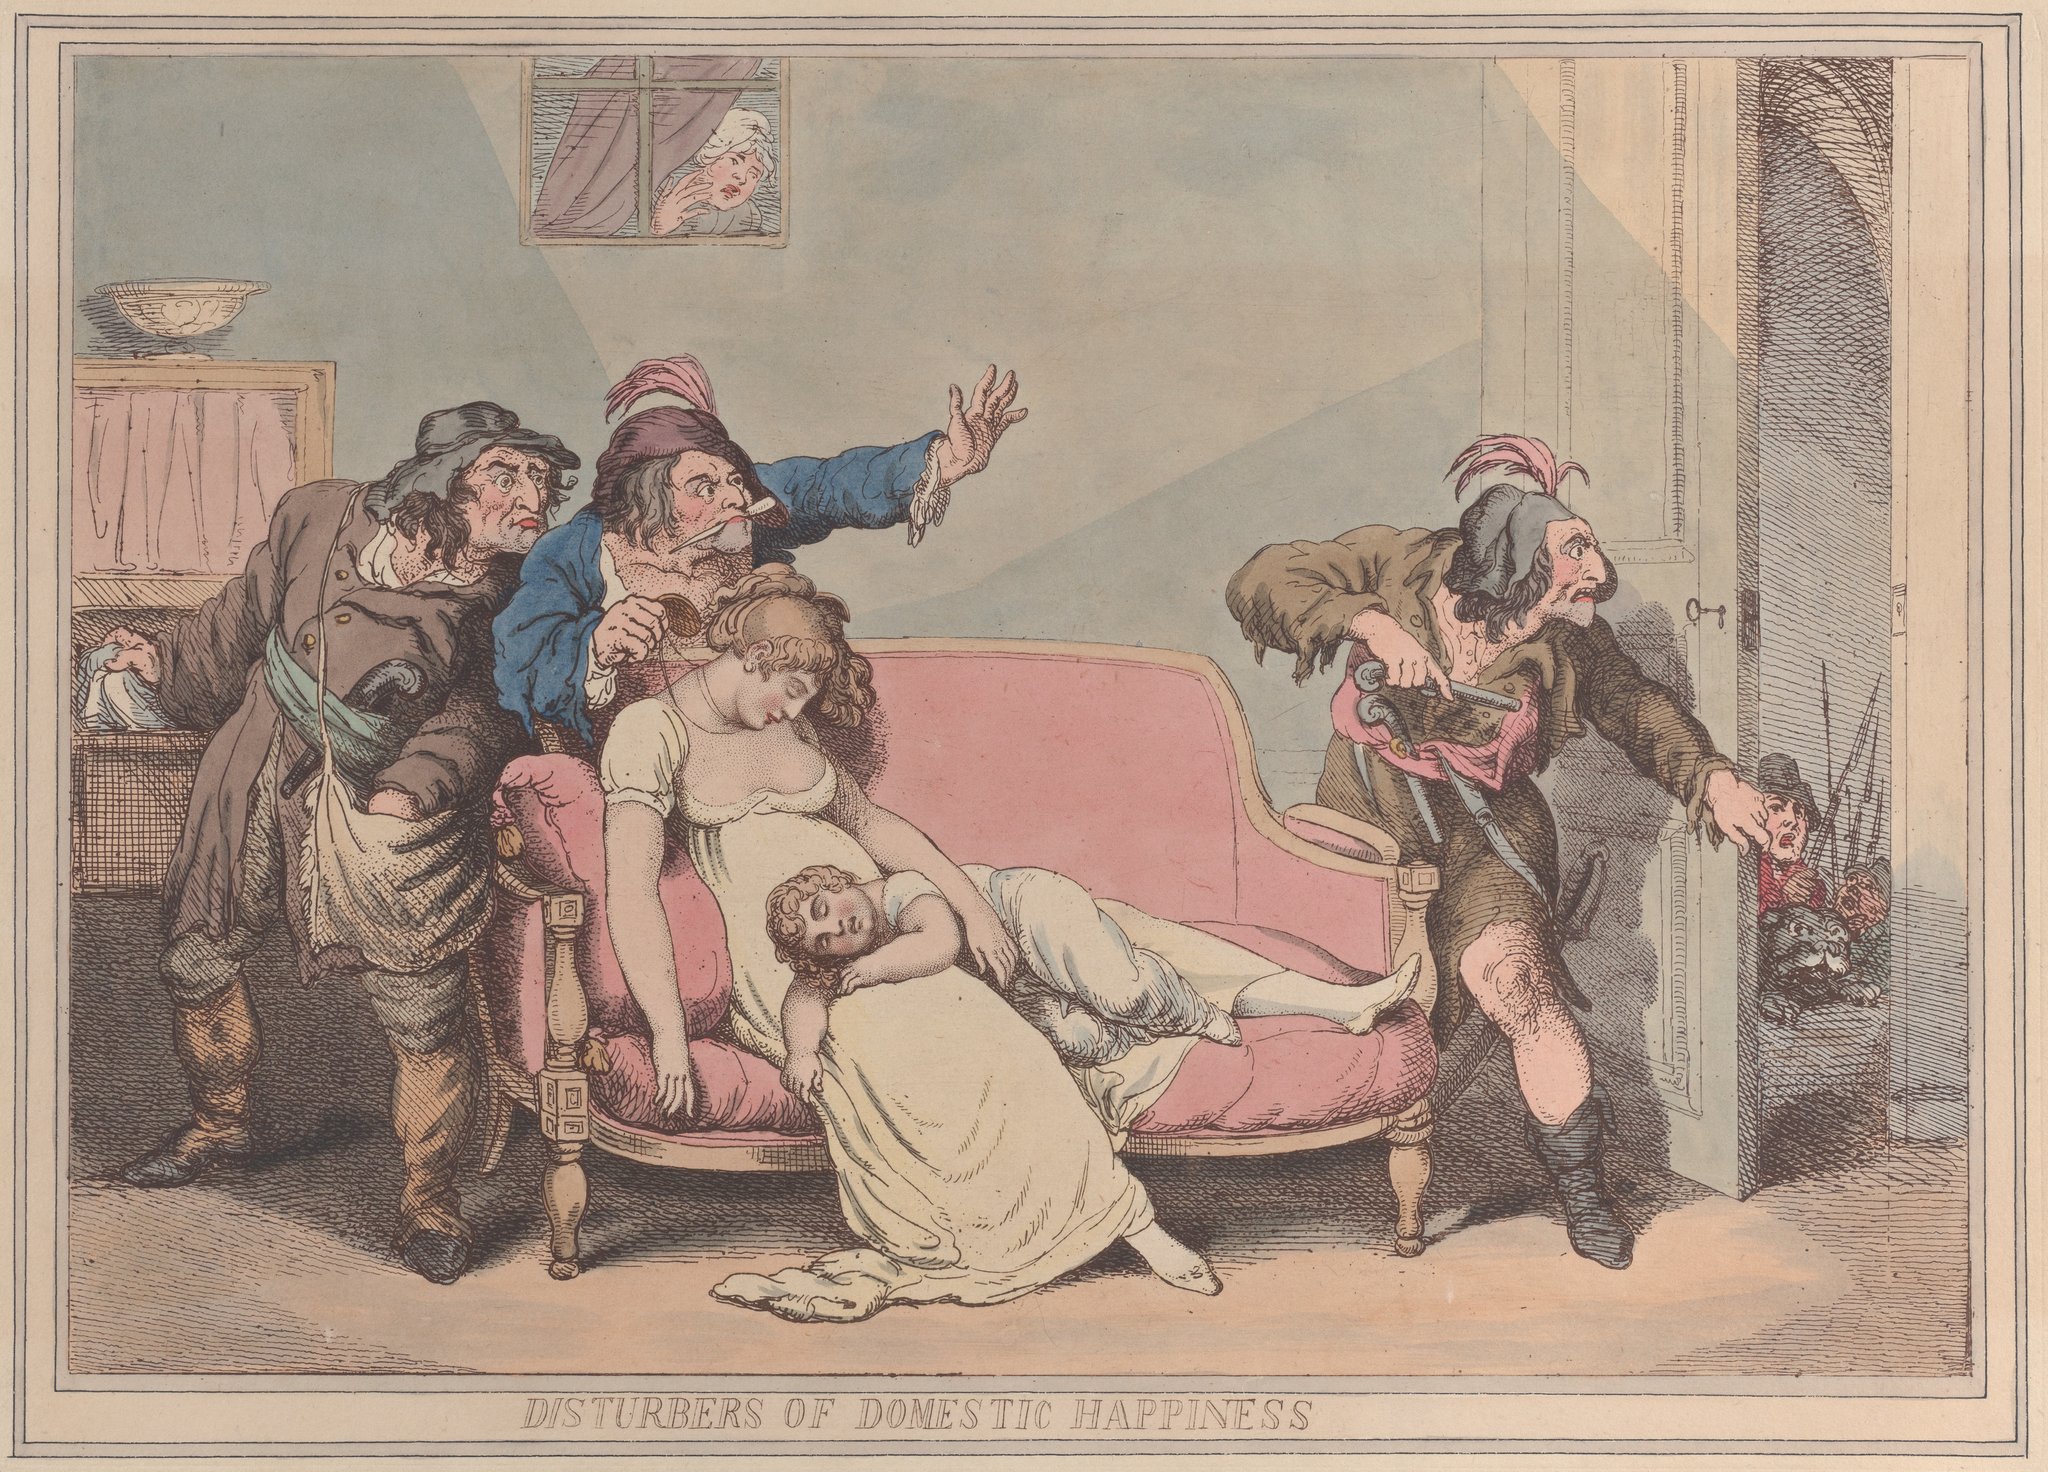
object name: print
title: Disturbers of Domestic Happiness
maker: thomas rowlandson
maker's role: artist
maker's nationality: british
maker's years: 1757-1827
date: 1815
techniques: etching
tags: satire,sleeping,children,men,women